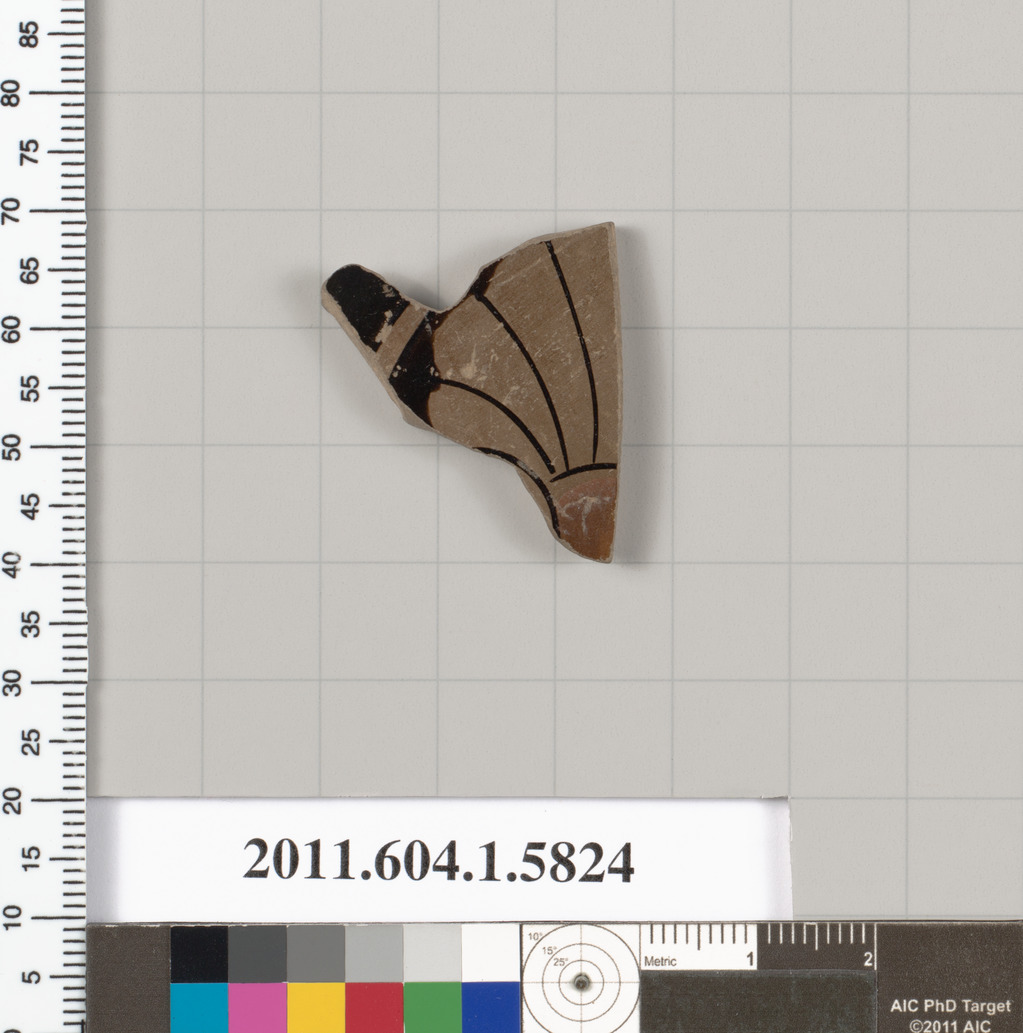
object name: kylix fragment, eye cup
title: Terracotta fragment of a kylix: eye-cup (drinking cup)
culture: greek, attic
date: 520-510 BCE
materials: terracotta